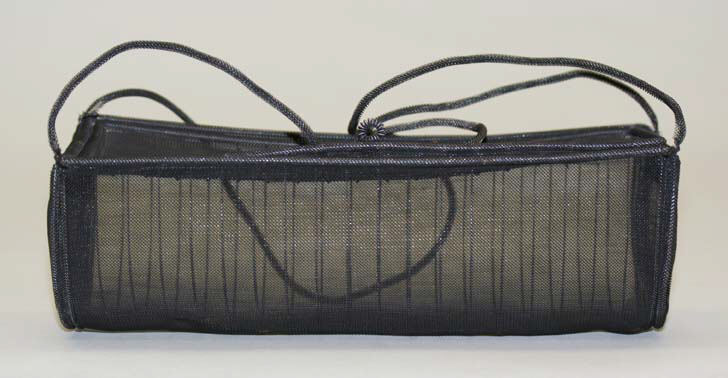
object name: purse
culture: european